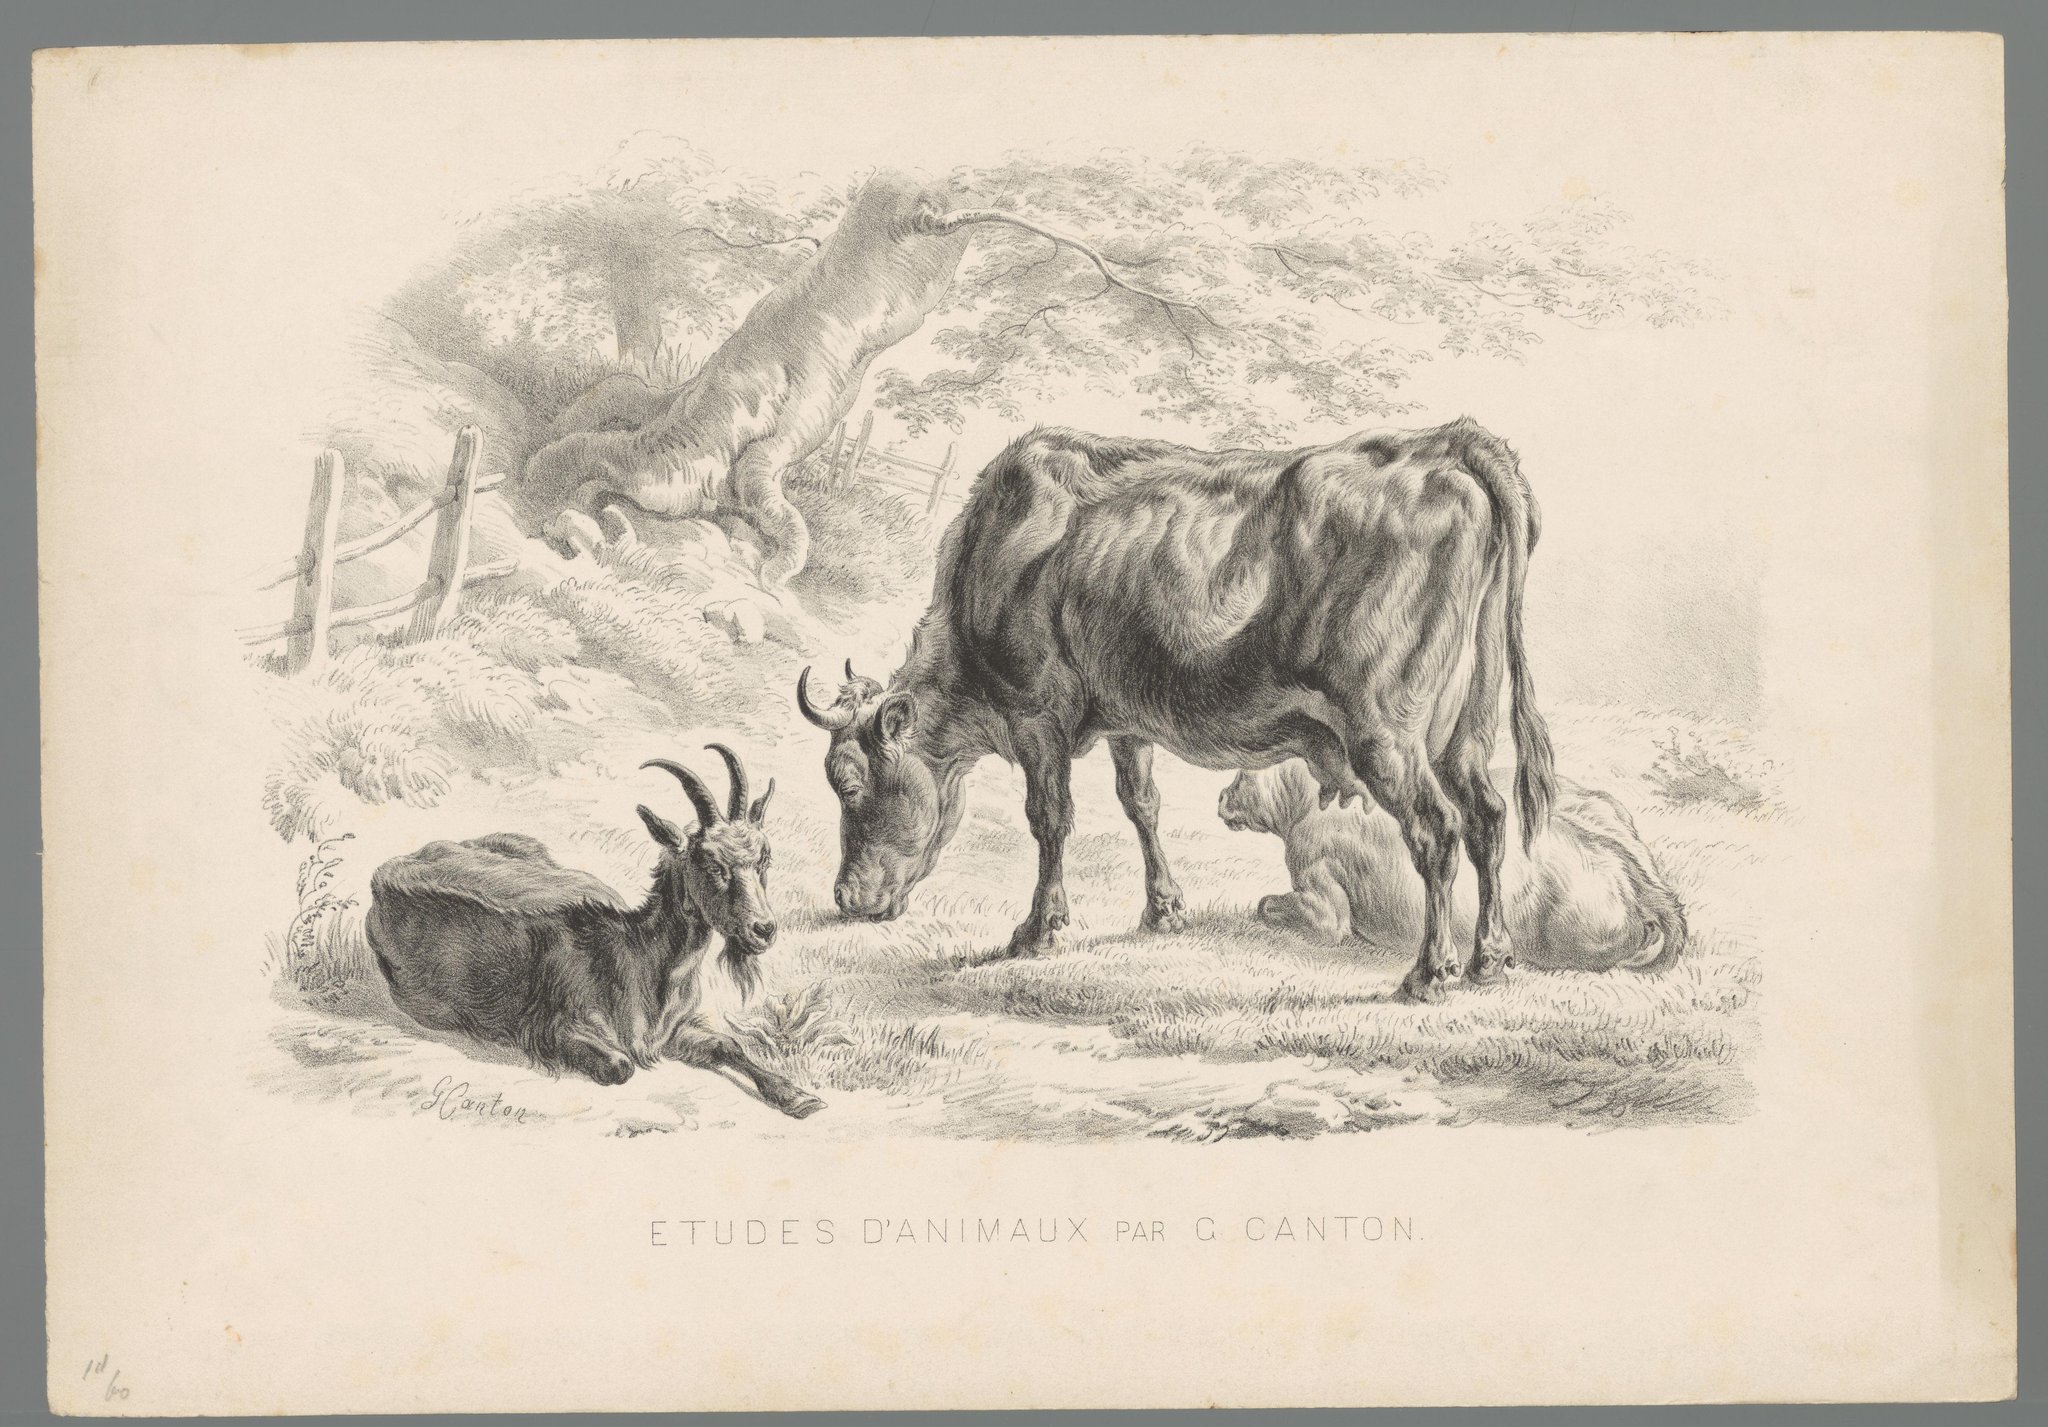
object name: print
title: Landschap met vee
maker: gustav jakob canton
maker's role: print maker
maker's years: 1813-1885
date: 1823-1885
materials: paper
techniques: lithograph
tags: landscapes, goat, bovine cattle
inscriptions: collector's mark: Lugt 2228